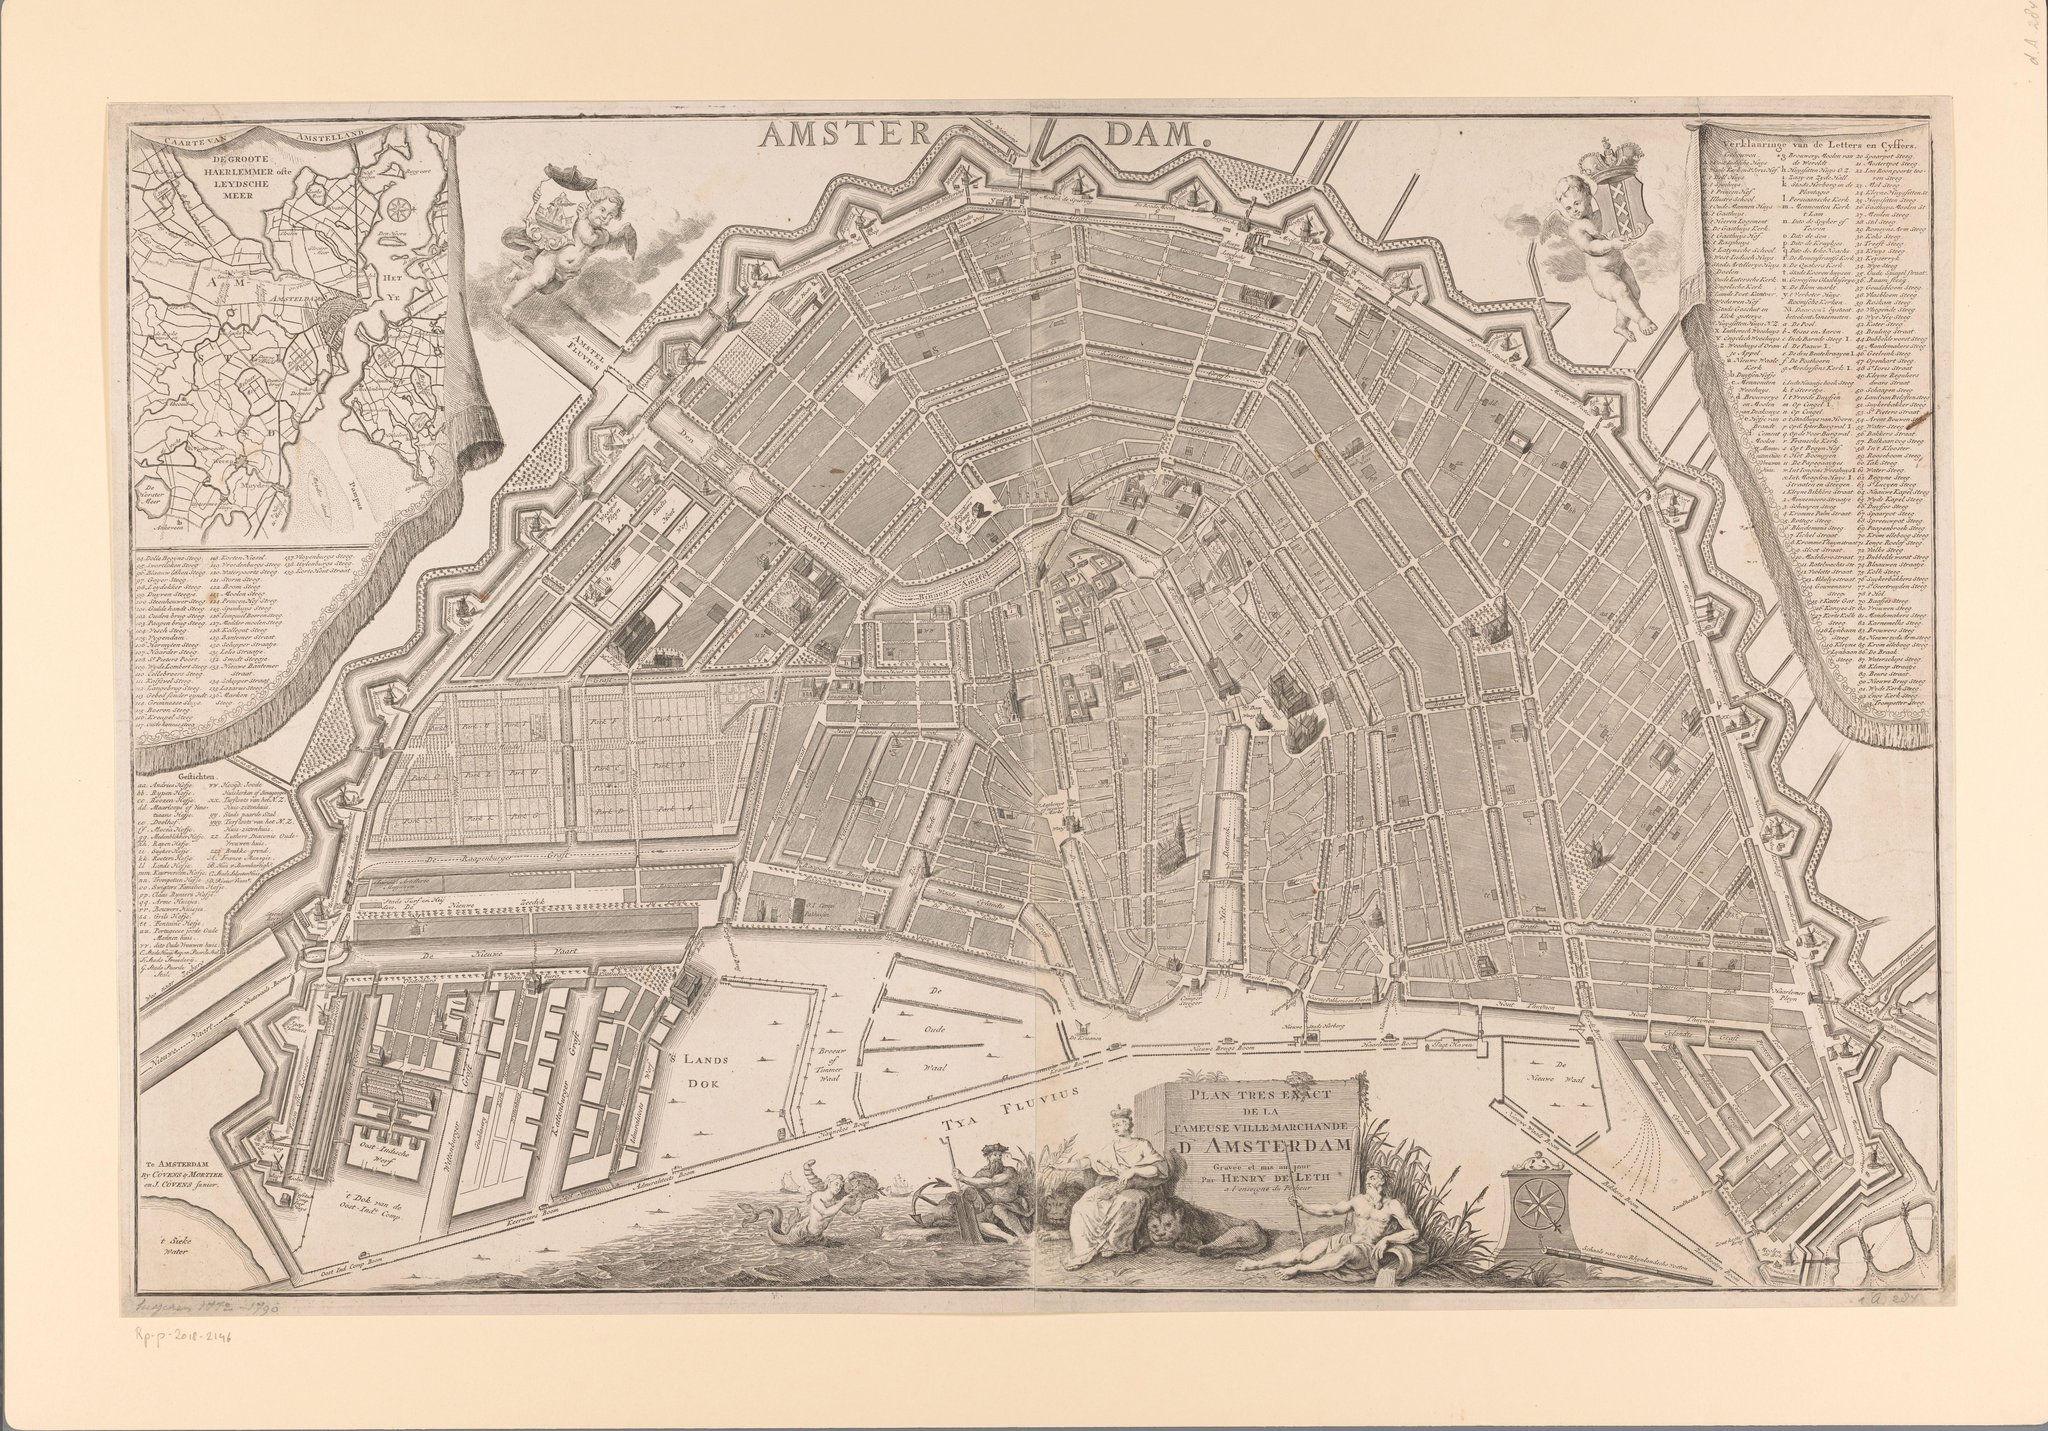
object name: area plan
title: Plattegrond van Amsterdam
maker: hendrik de leth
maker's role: draughtsman, print maker, publisher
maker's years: 1703-1766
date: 1774-1783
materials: paper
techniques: engraving, etching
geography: amsterdam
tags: coat of arms (as symbol of the state, etc.) (+ city; municipal), maps of separate countries or regions, maps of cities, amsterdam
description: Linksboven een inzet met een kaart van de omgeving van Amsterdam.